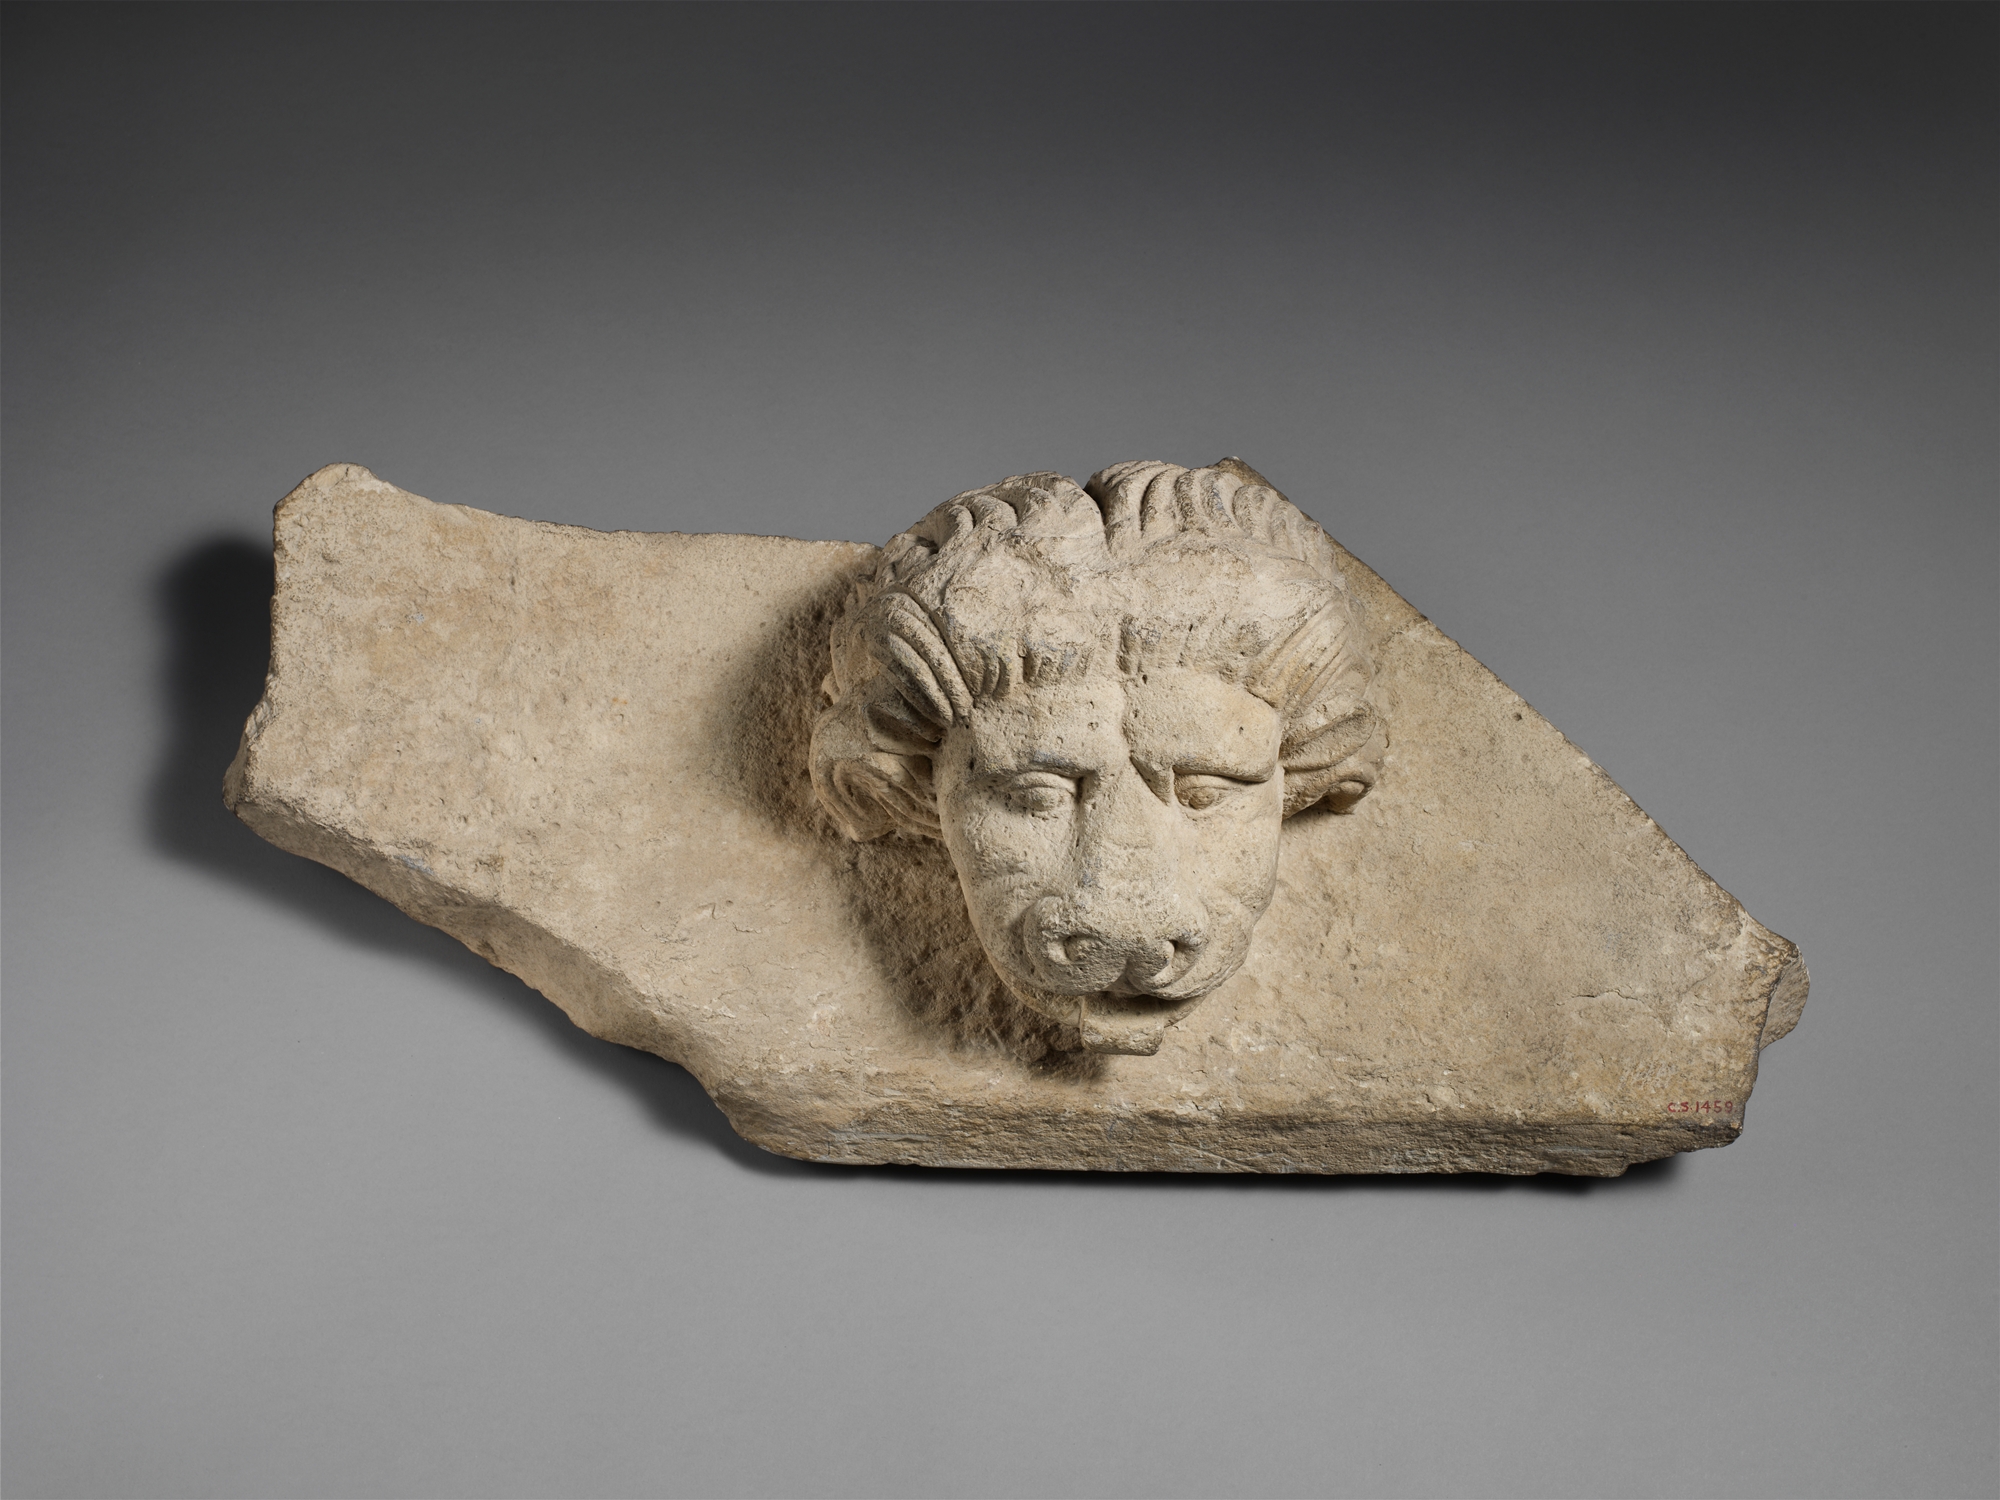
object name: capital cornice fragment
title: Limestone cornice with a lion’s head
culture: cypriot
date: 400-368 BCE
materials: limestone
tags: lions